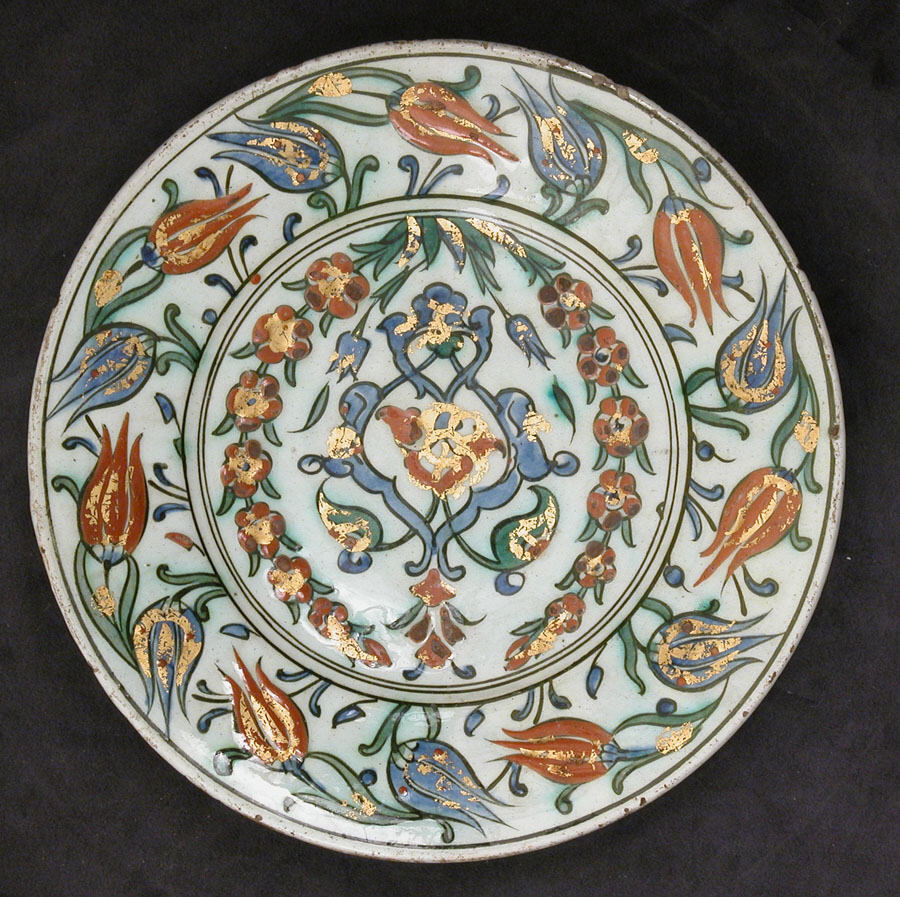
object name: dish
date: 1601-1700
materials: earthenware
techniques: glazing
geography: turkey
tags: flowers